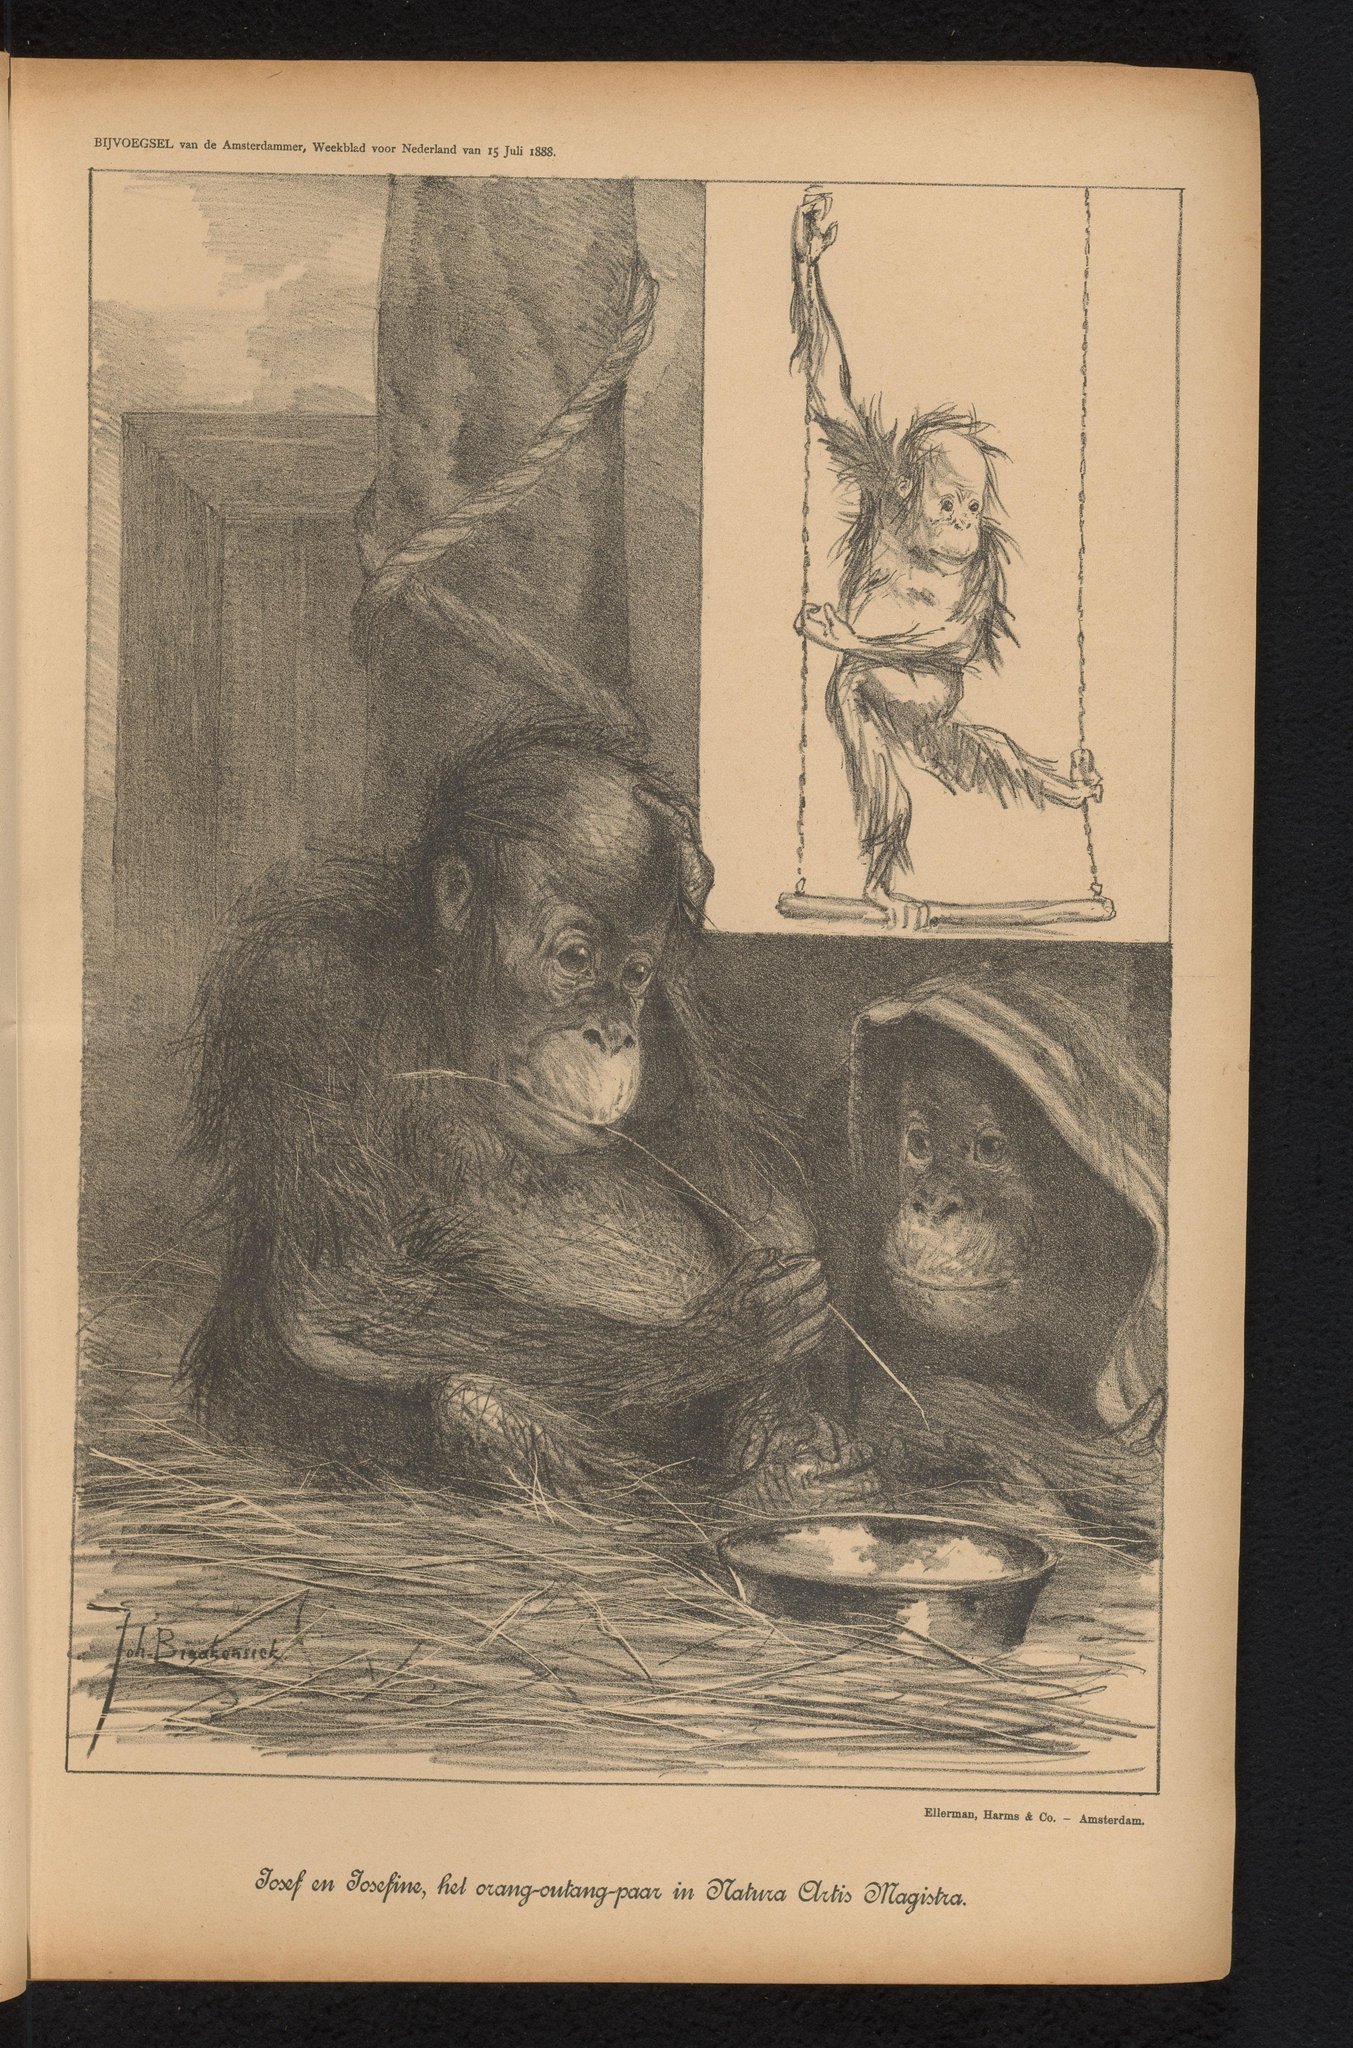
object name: print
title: Josef en Josefine, het orang-outang-paar in Natura Artis Magistra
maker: johan braakensiek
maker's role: draughtsman, print maker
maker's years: 1858-1940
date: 1888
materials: paper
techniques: lithograph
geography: amsterdam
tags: monkeys, apes: orang-utan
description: De orang-oetans genaamd Josef en Josefine, in hun hok in de dierentuin Artis.